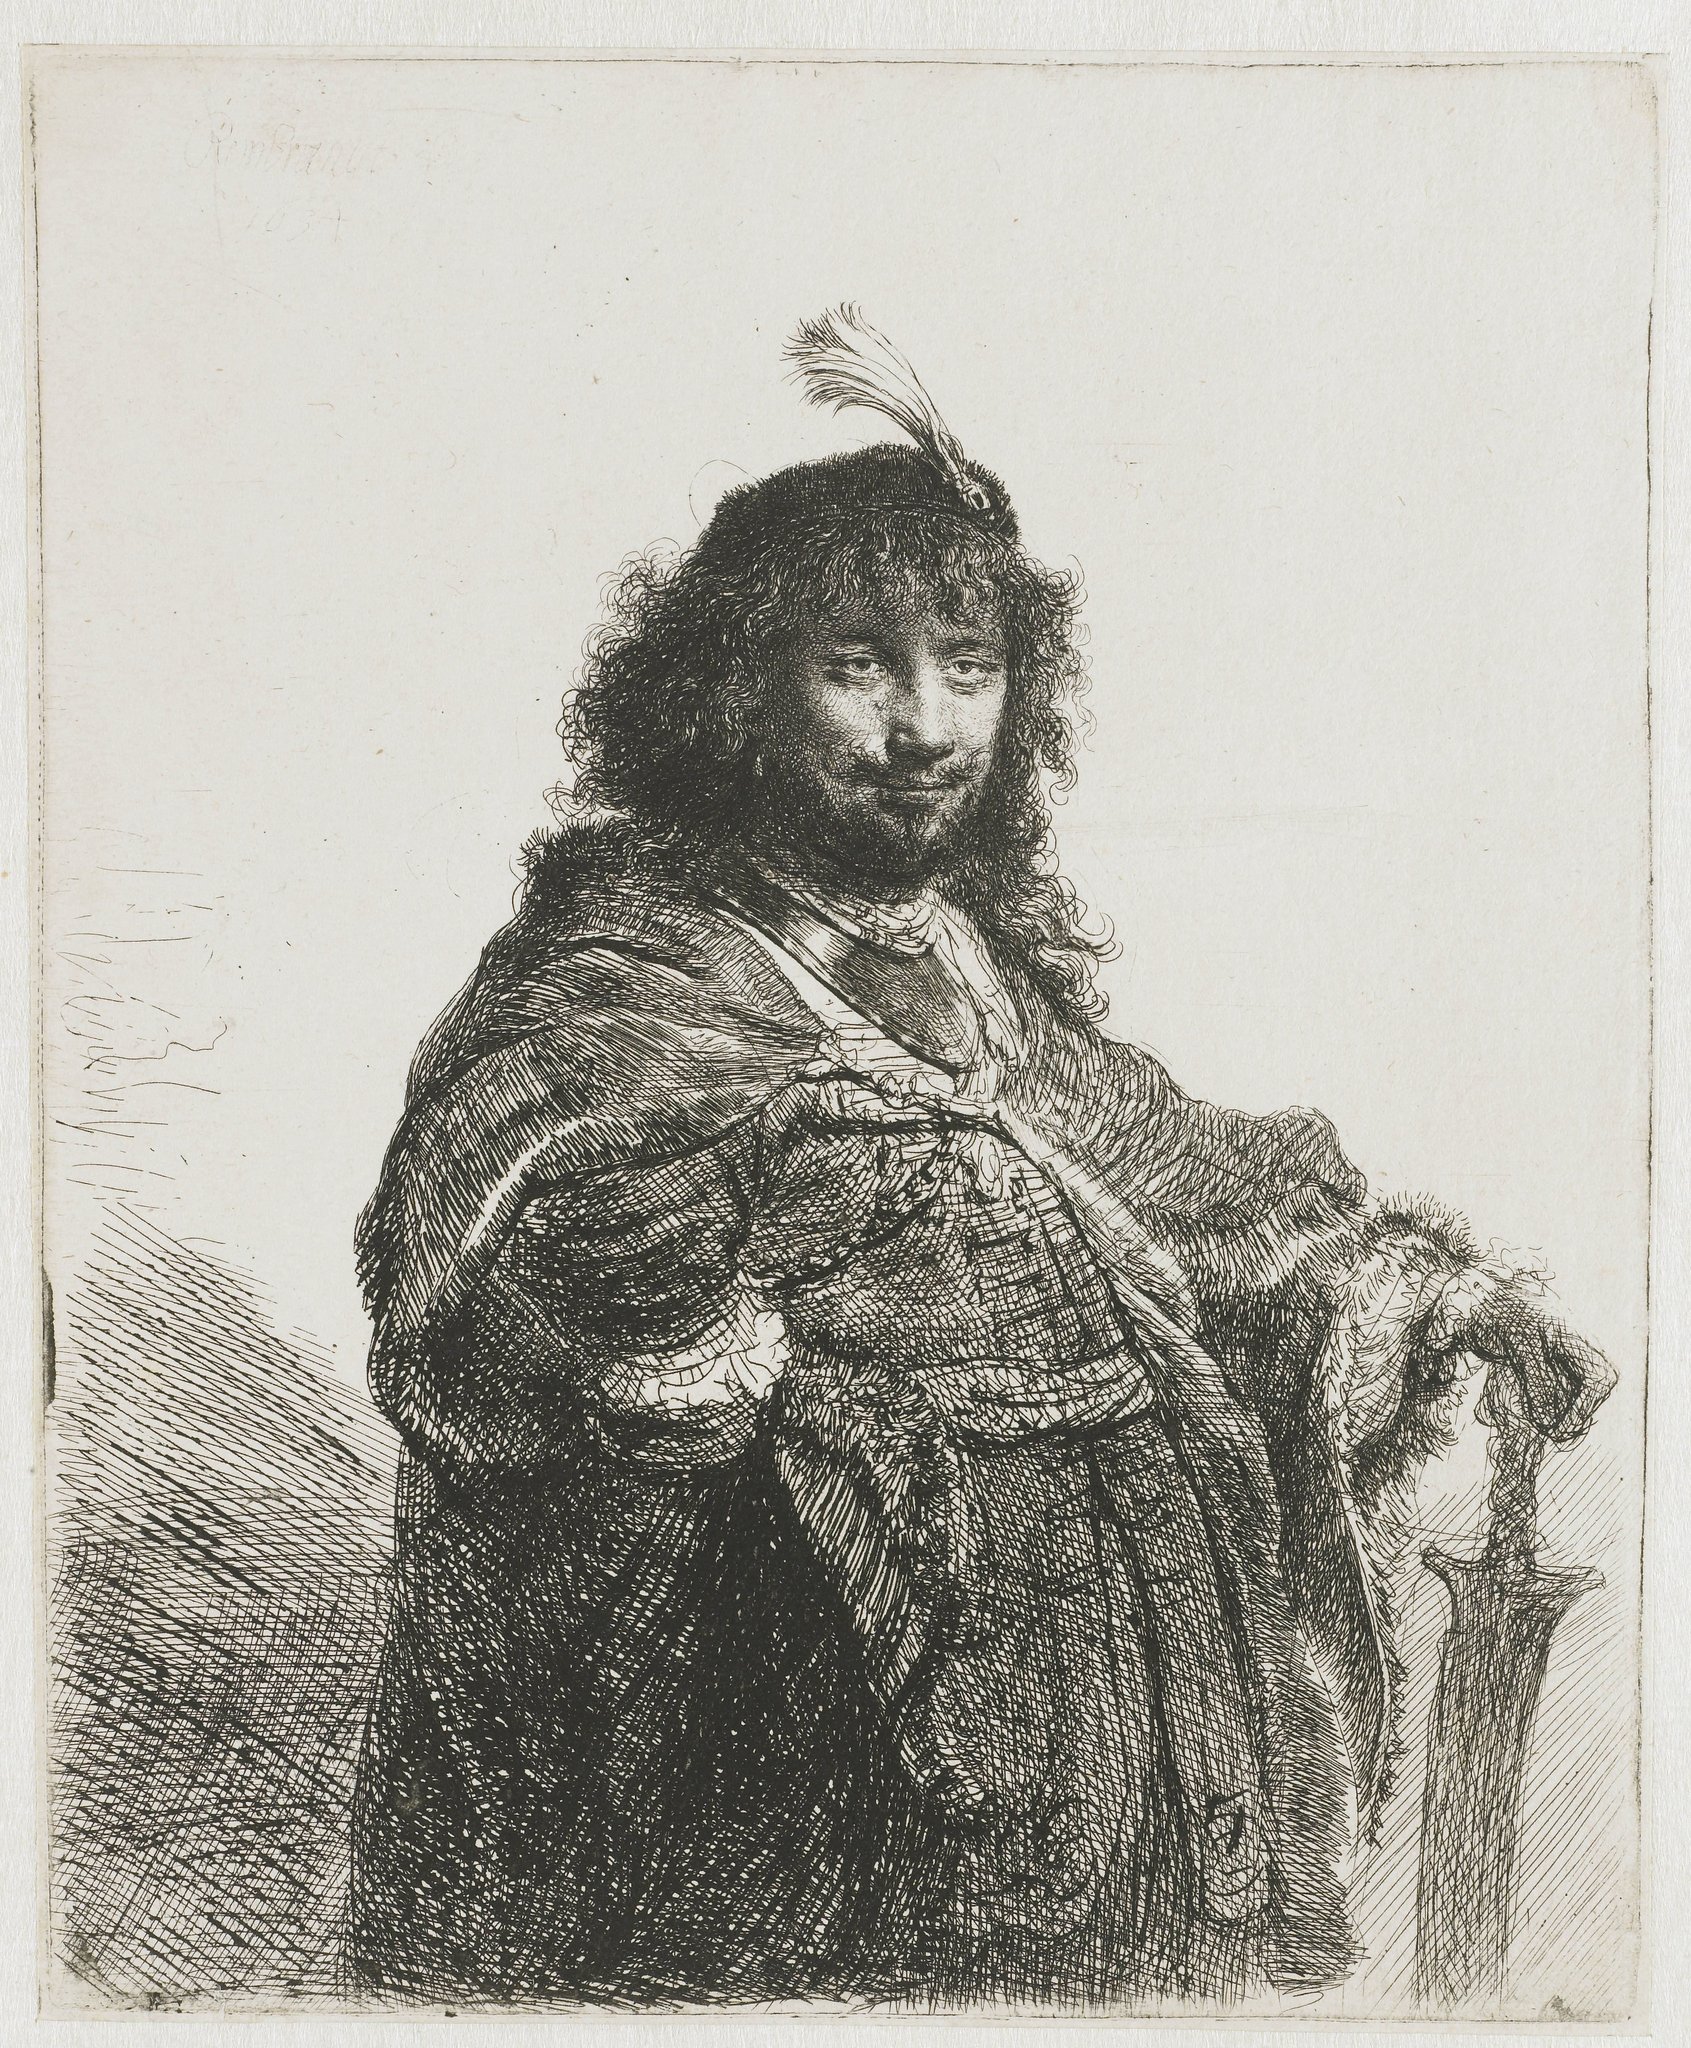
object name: print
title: Self-portrait (?) with Plumed Cap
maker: rembrandt van rijn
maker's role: draughtsman, painter, print maker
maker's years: 1606-1669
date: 1634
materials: paper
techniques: etching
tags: leiden, amsterdam, painter, print maker, draughtsman, rembrandt van rijn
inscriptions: signature and date: ‘Rembrandt f. 1634’, collector's mark: Lugt 240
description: In his early self-portraits, Rembrandt often practises rendering light or emotions. By contrast, these later ones are more narrative, because he dresses up in imaginary costumes (e.g. complete with an Oriental sword) or in 16th-century attire. With the latter variant, he aligns himself with celebrated 16th-century artists, such as Lucas van Leyden, Titian or Raphael.